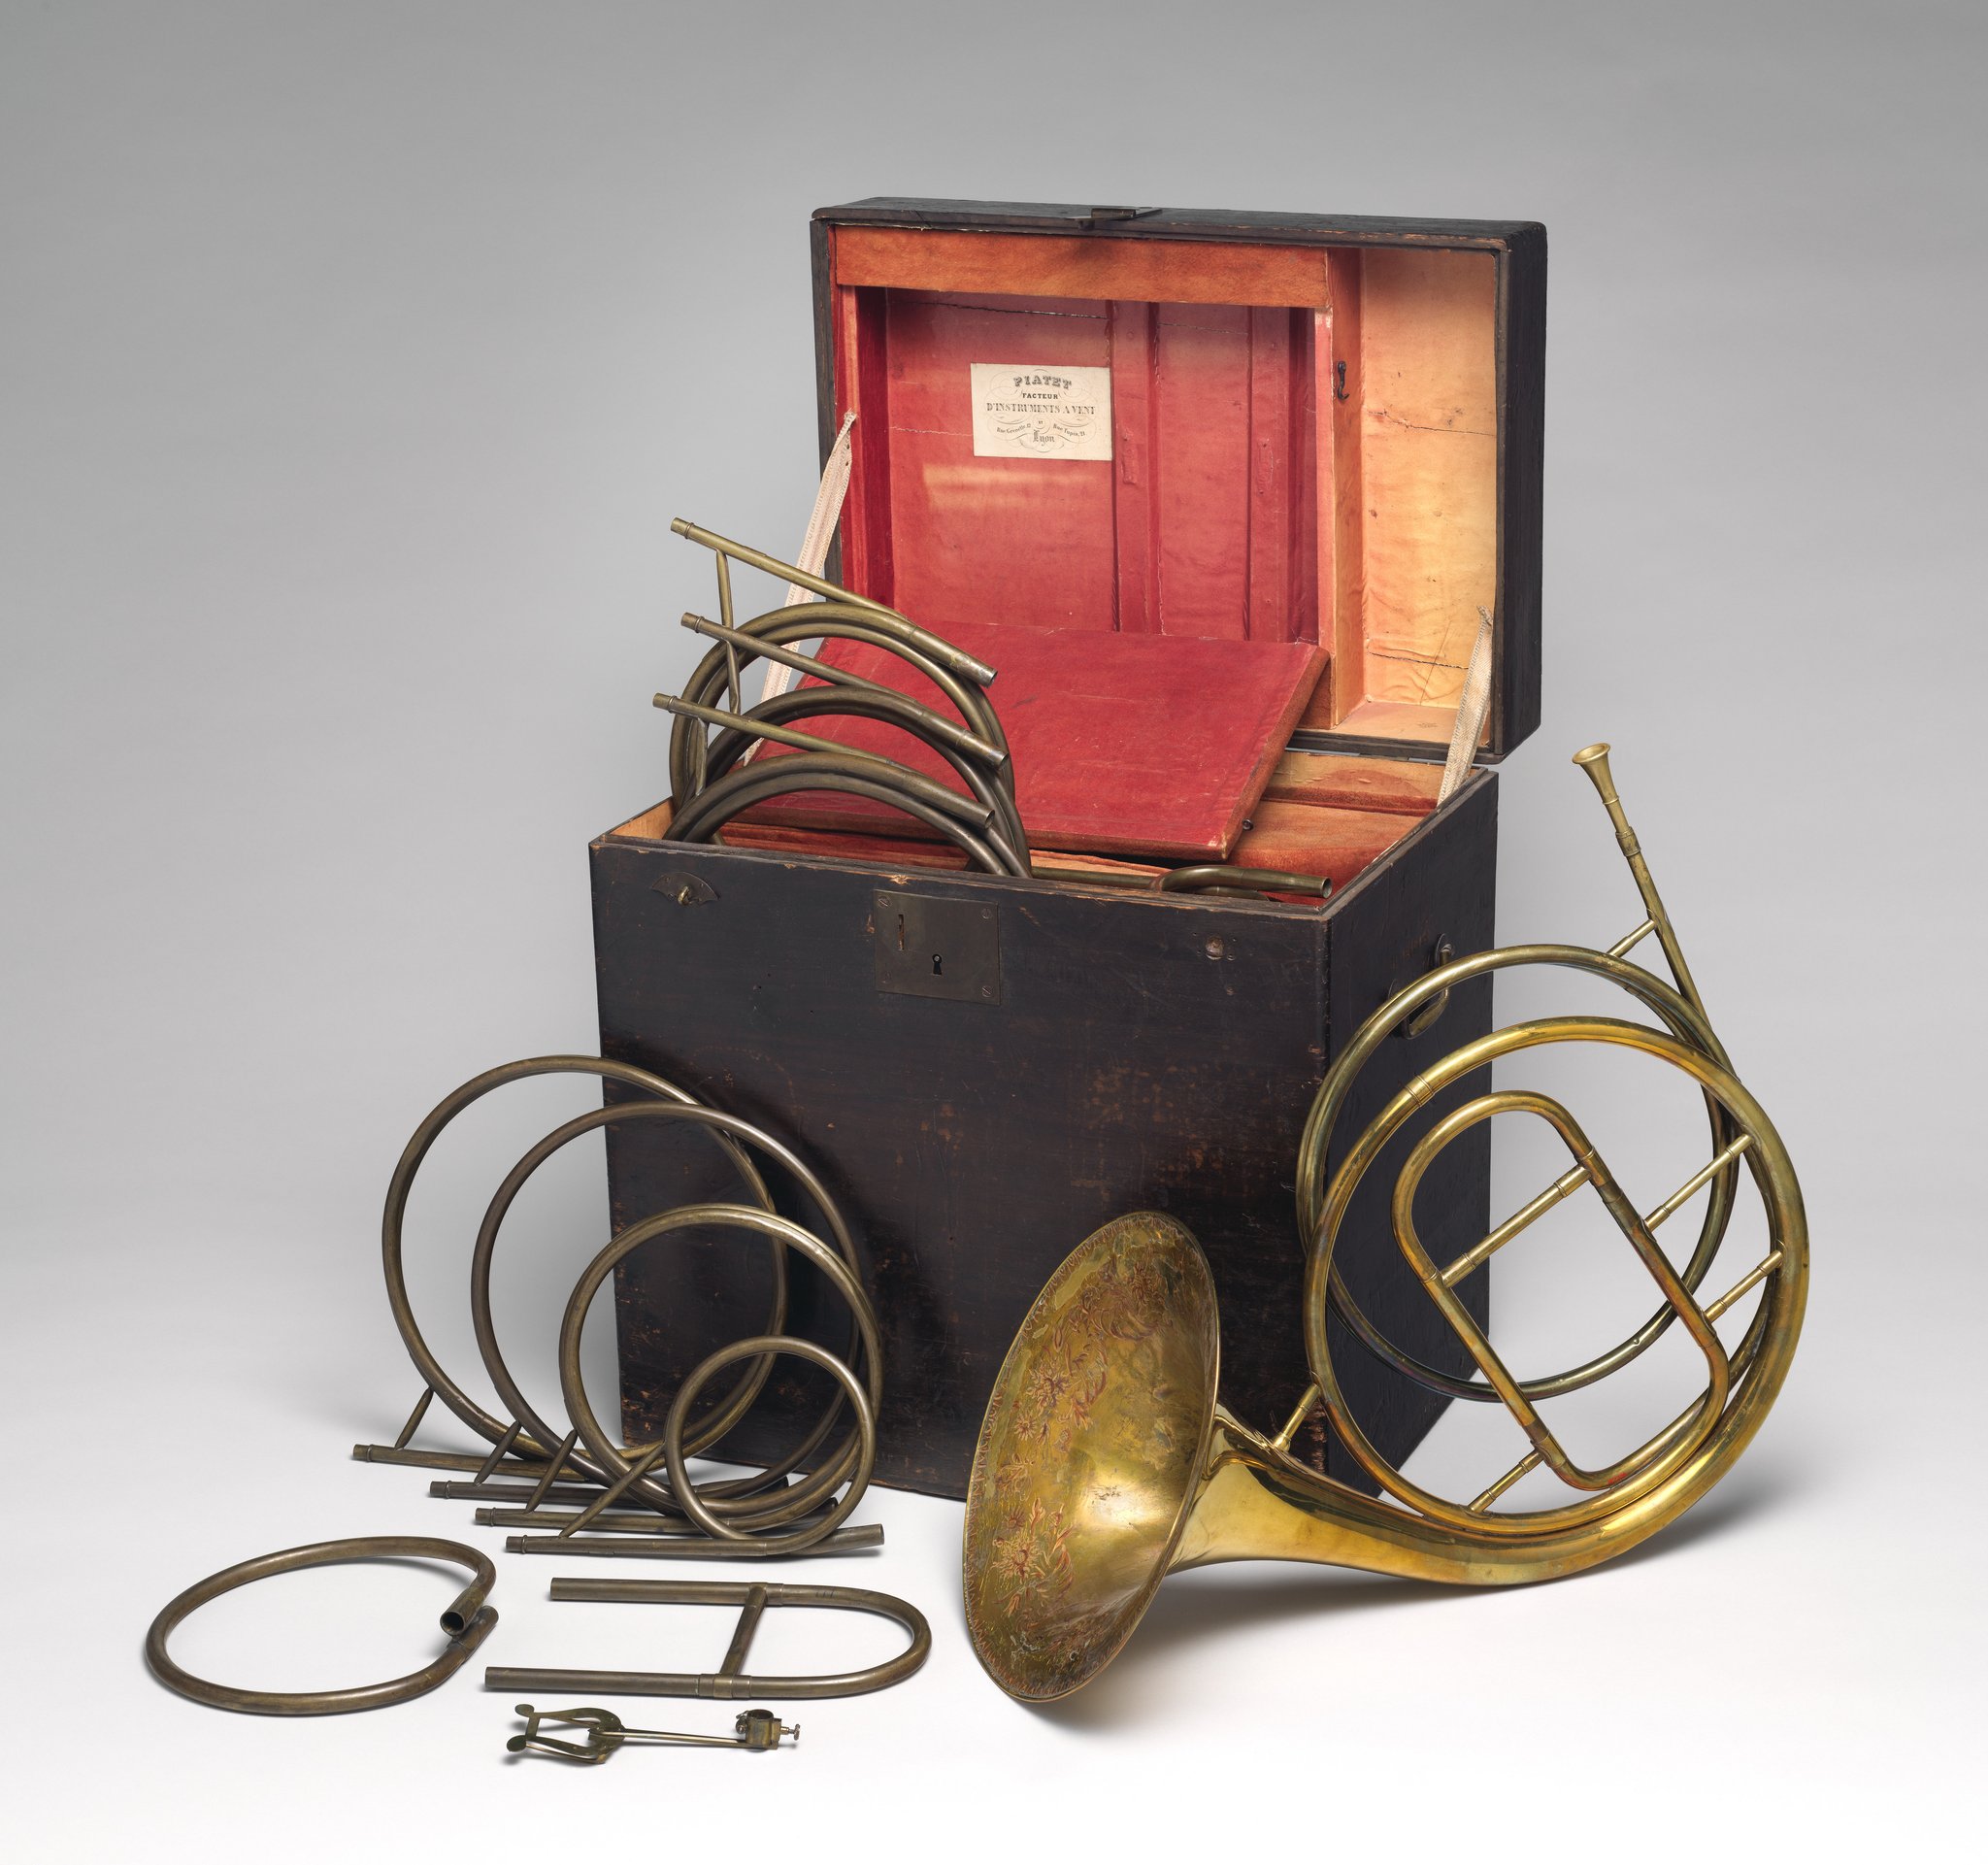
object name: cor d orchestre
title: Cor d'orchestre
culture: french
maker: pierre piatet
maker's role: maker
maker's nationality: french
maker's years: 1796-1868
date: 1845-1850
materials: brass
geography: france